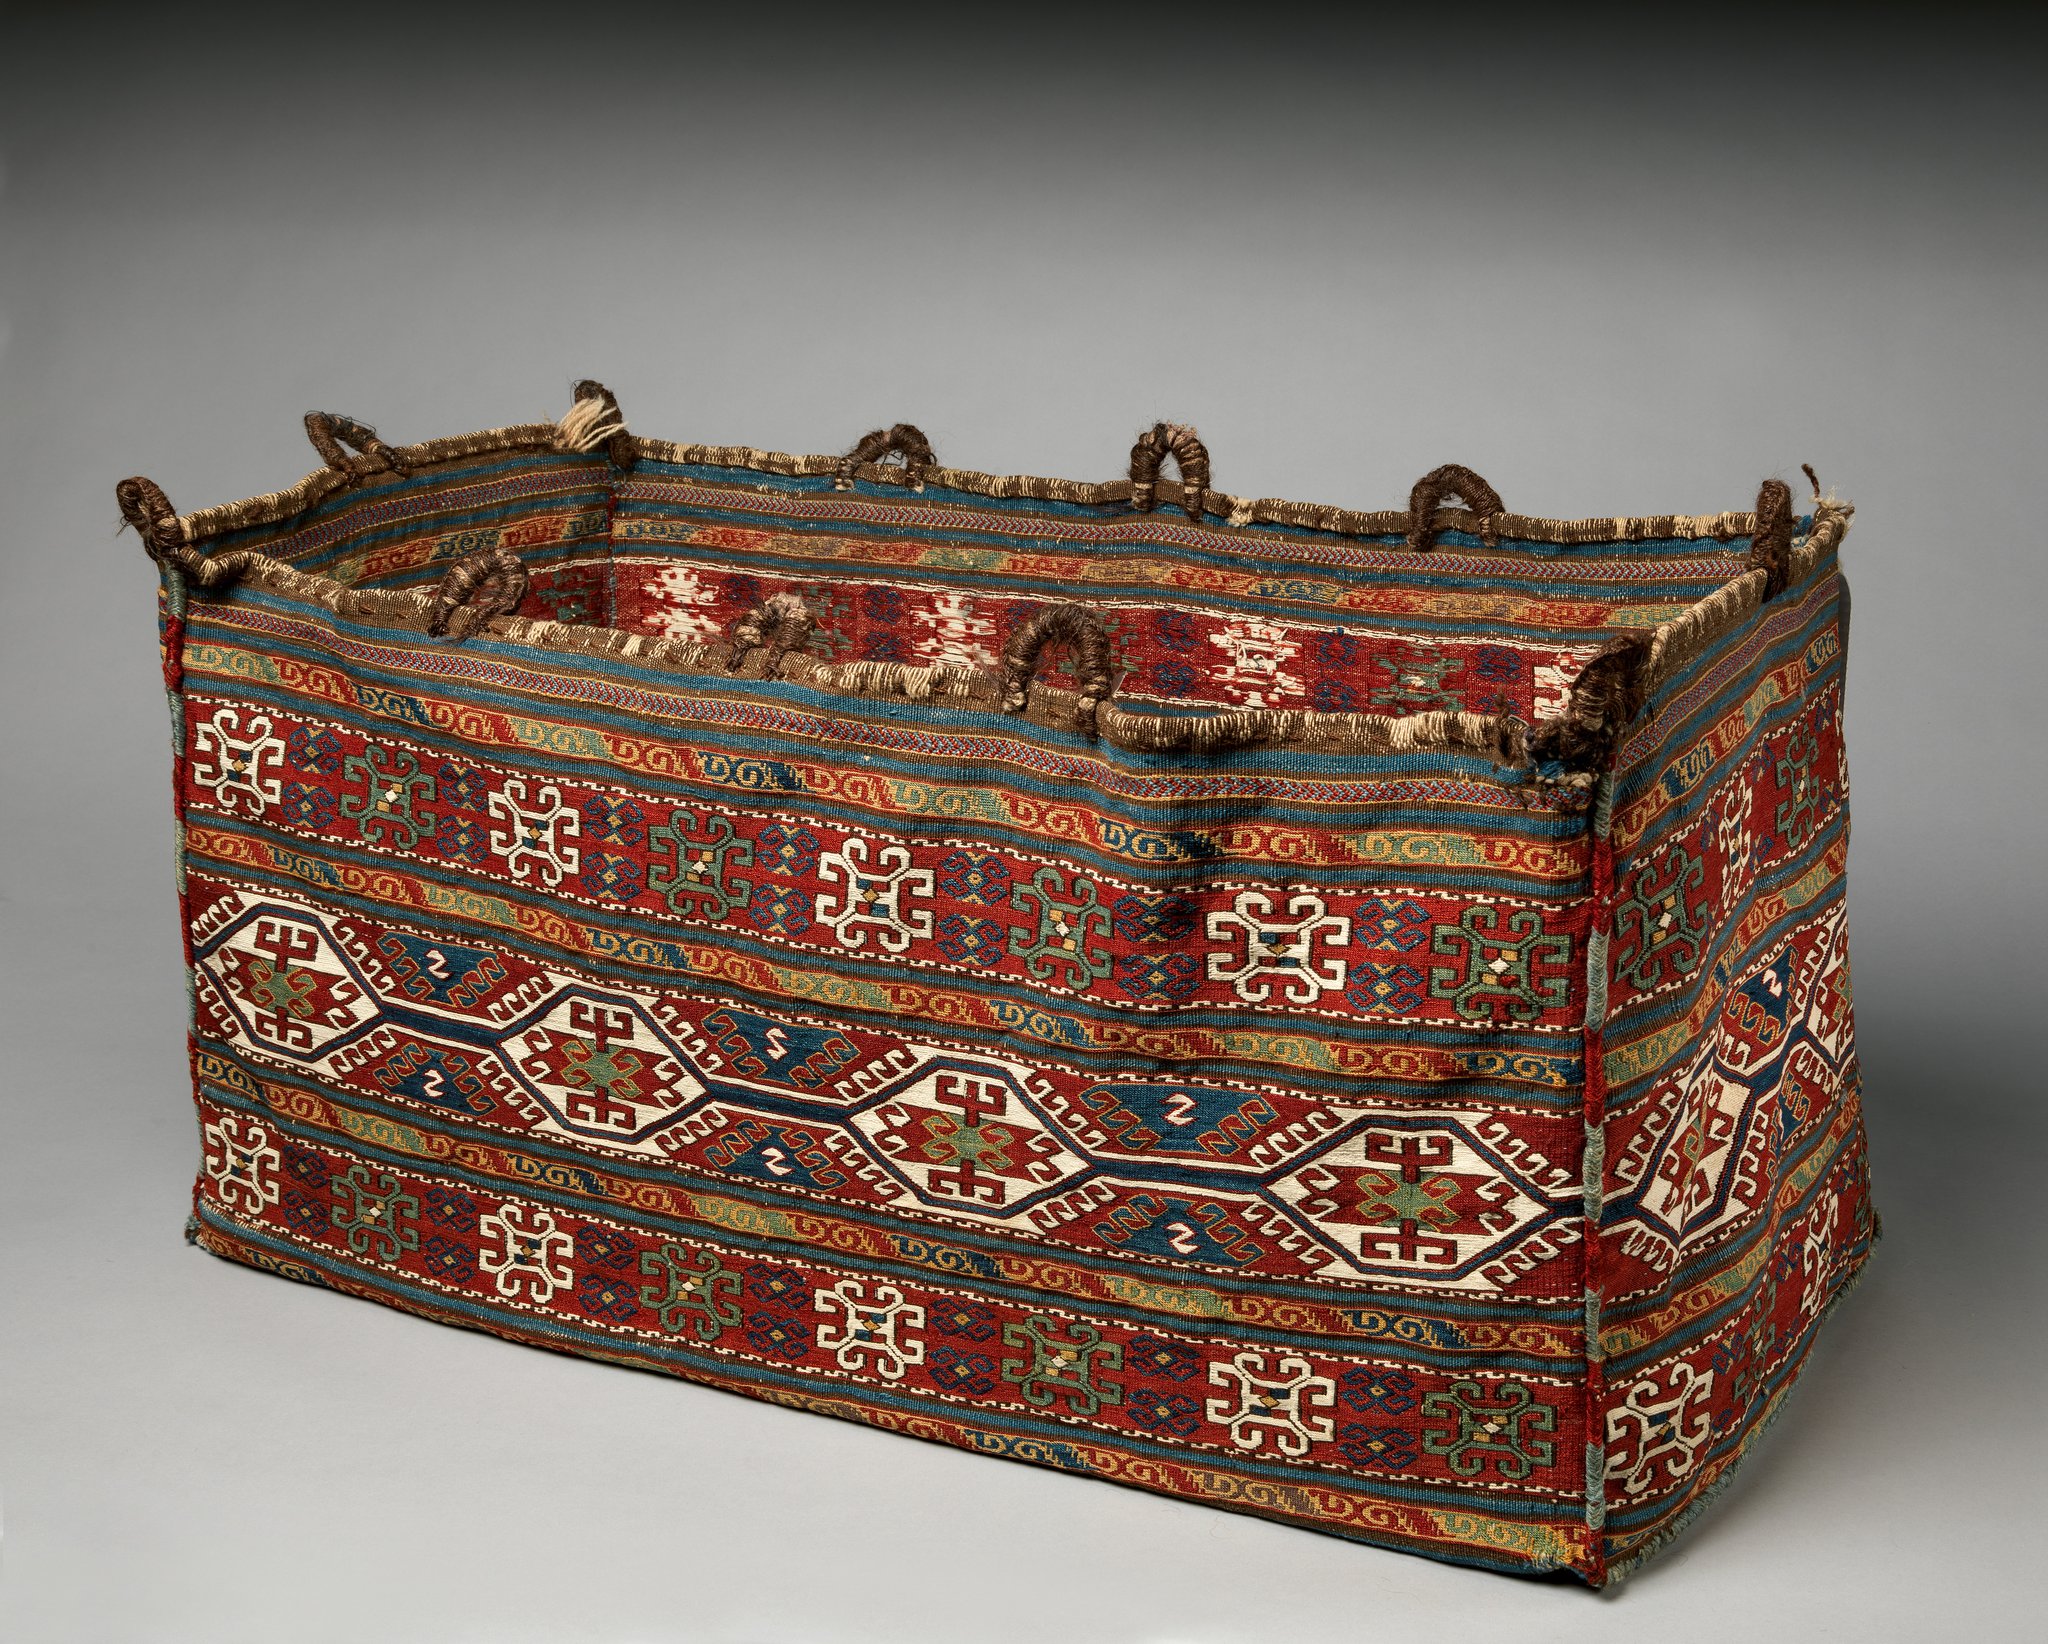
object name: bag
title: Bedding Bag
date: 1825-1875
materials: cotton, hair, wool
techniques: weave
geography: iran